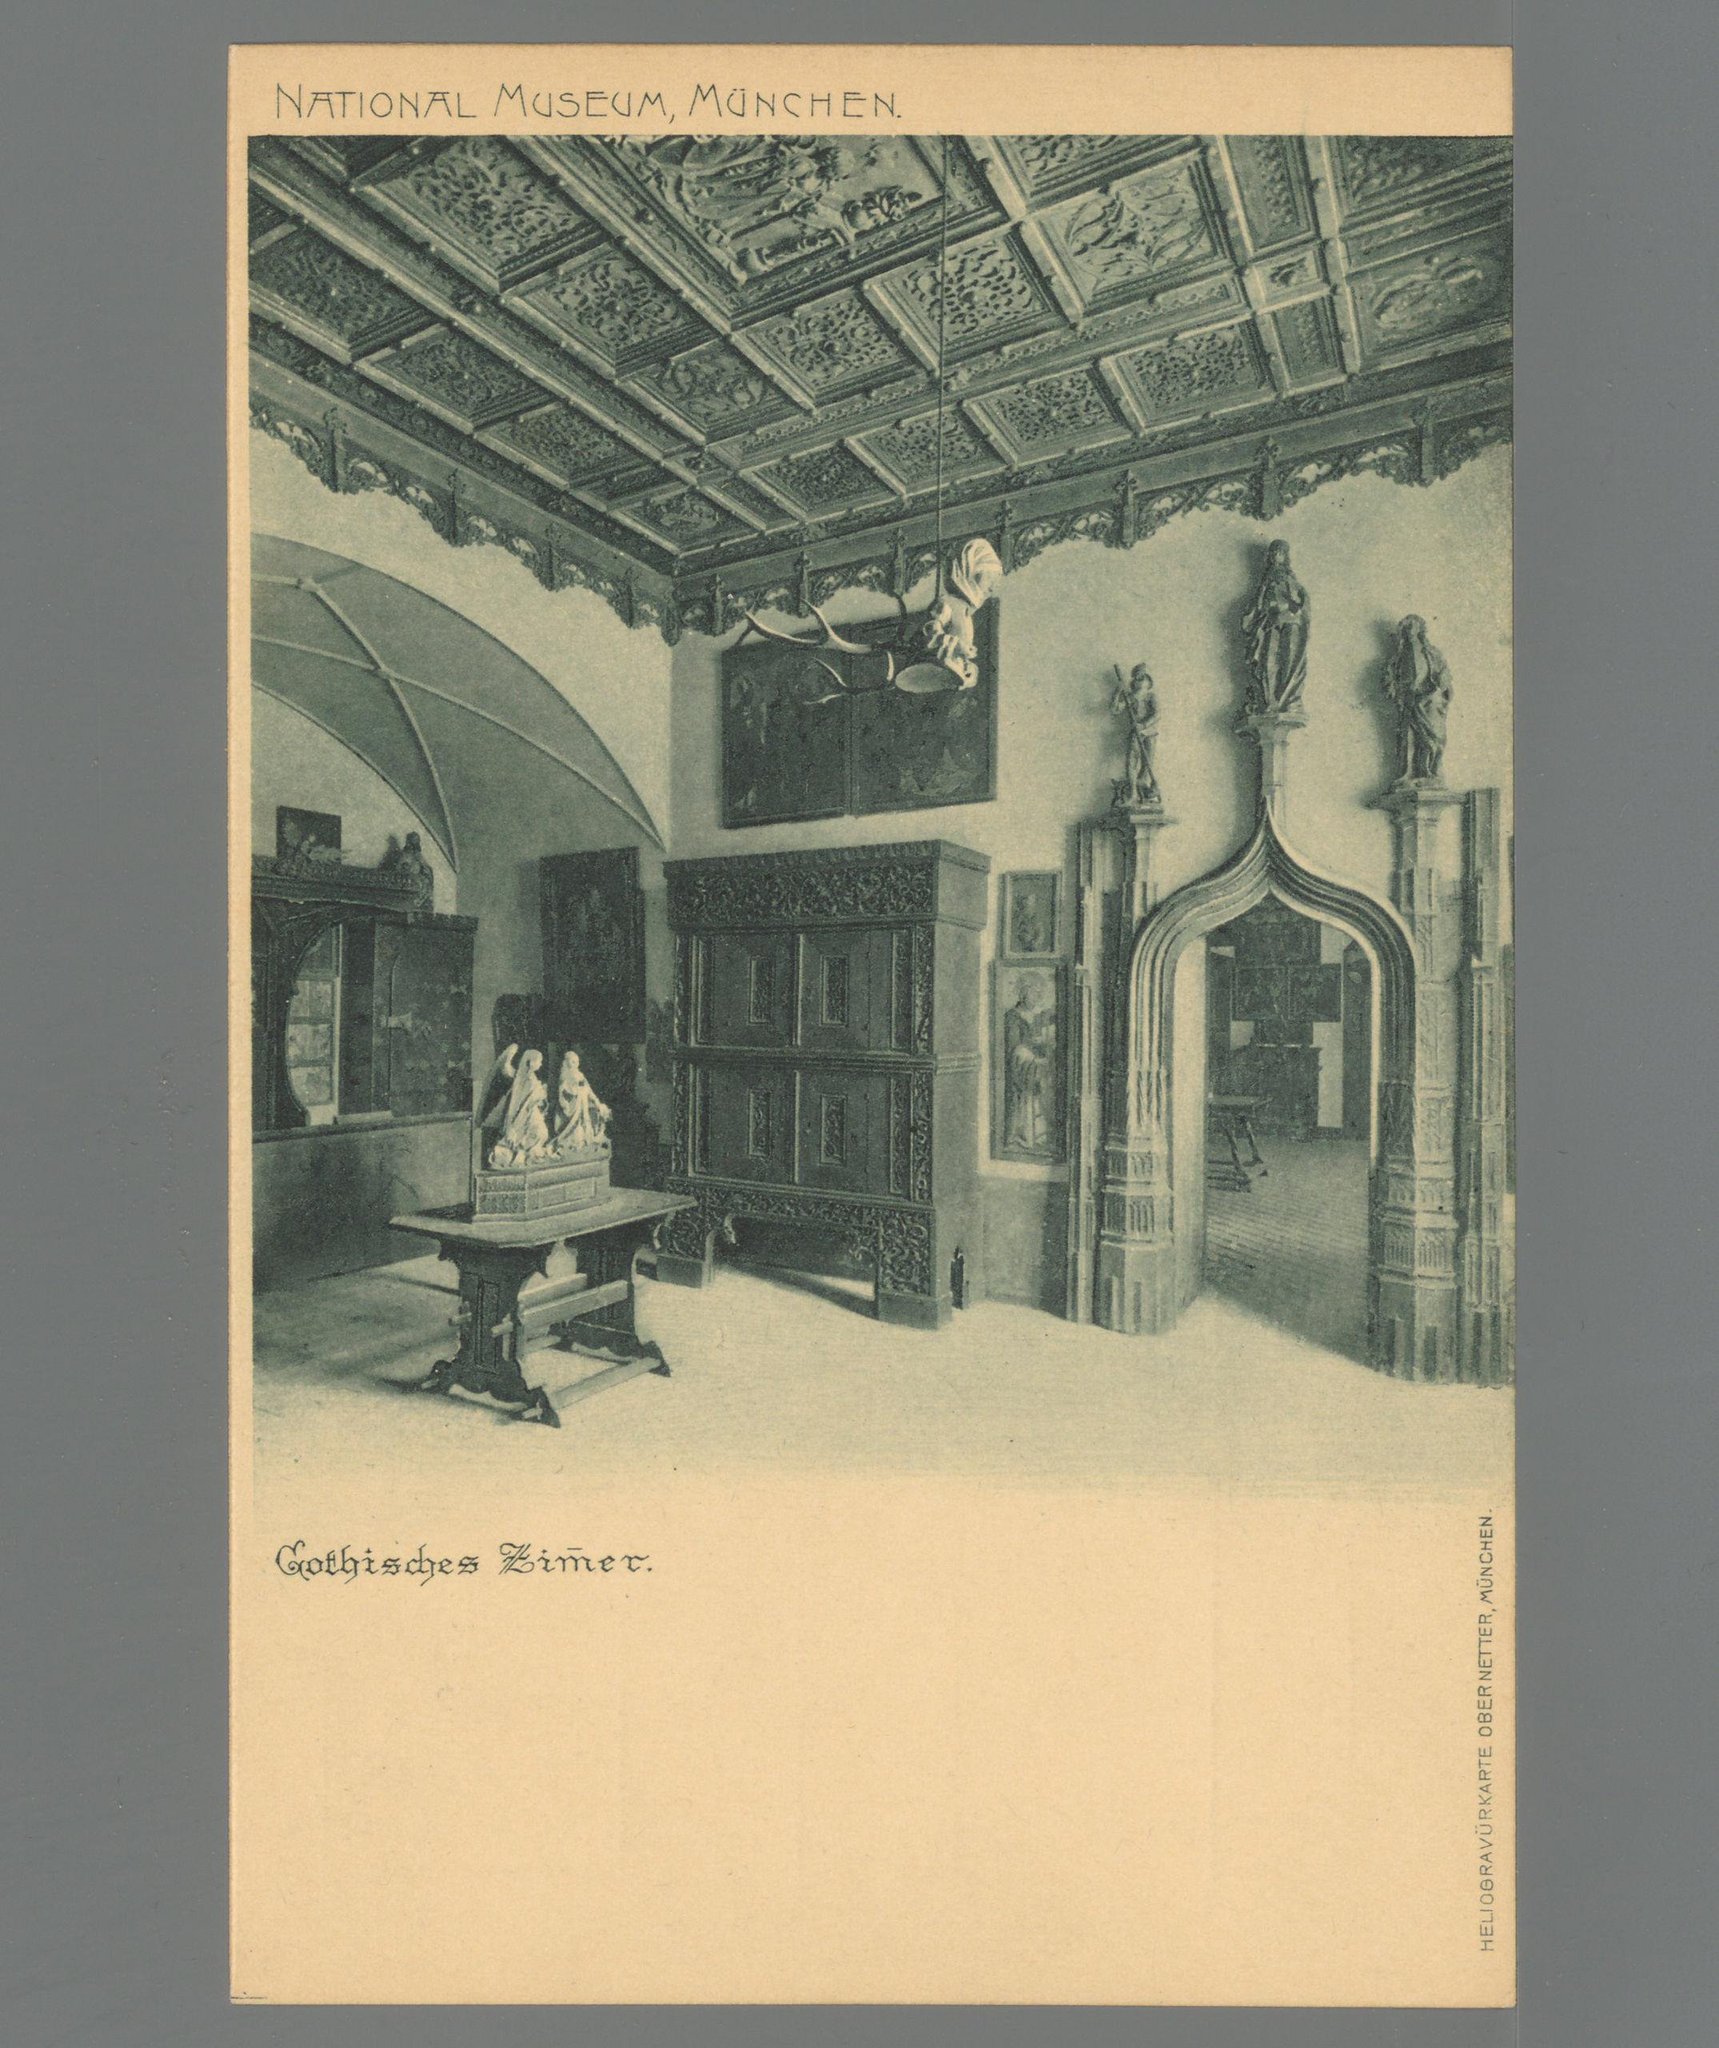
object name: photomechanical print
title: National Museum, München. Gothisches Zimer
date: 1885-1905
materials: cardboard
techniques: photoaquatint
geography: munich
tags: permanent exhibition, museum